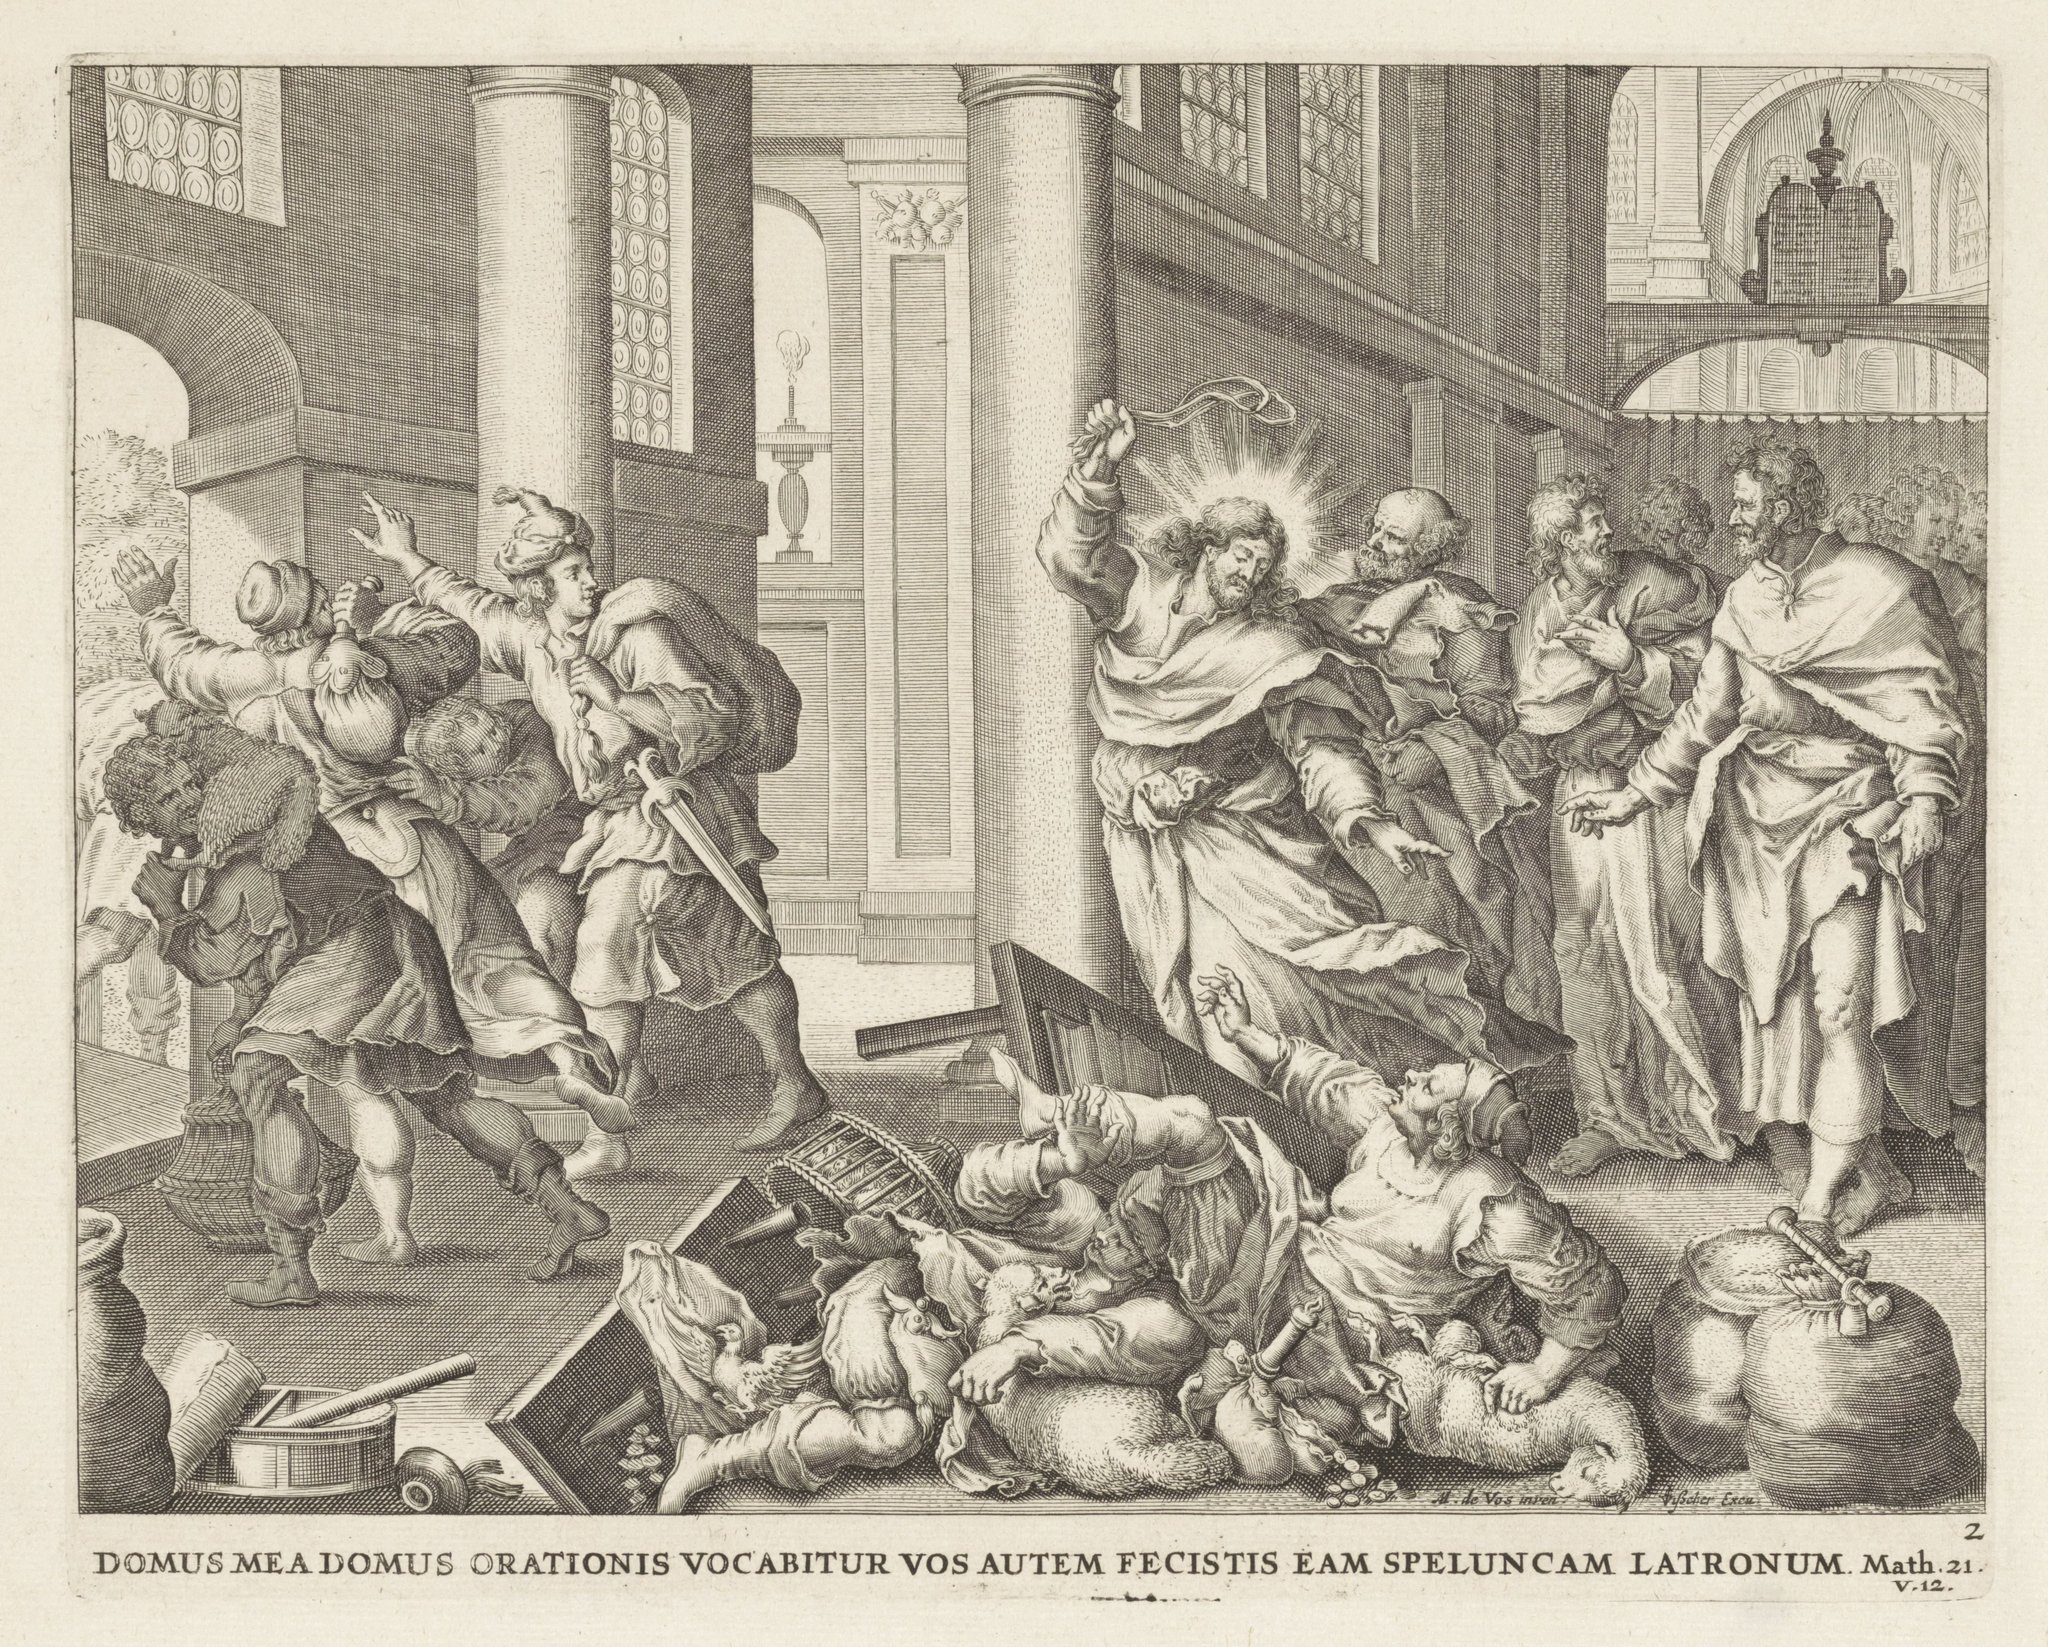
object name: print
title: Gebeurtenissen in en rond de tempel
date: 1643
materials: paper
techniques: engraving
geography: amsterdam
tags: purification of the temple ('first' and 'second'): christ driving the money-changers from the temple with a whip (matthew 21:12-13; mark 11:15-17; luke 19:45-46; john 12:12-19)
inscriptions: collector's mark: Lugt 2760, collector's mark: Lugt 2228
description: Christus verdrijft met een zweep de handelaren en geldwisselaars uit de tempel. Links vluchten drie mannen weg. Op de voorgrond liggen twee mannen bij hun omgevallen tafels, geld en koopwaar op de grond. Onder de voorstelling een verwijzing in het Latijn naar de Bijbeltekst in Mat. 21:12.